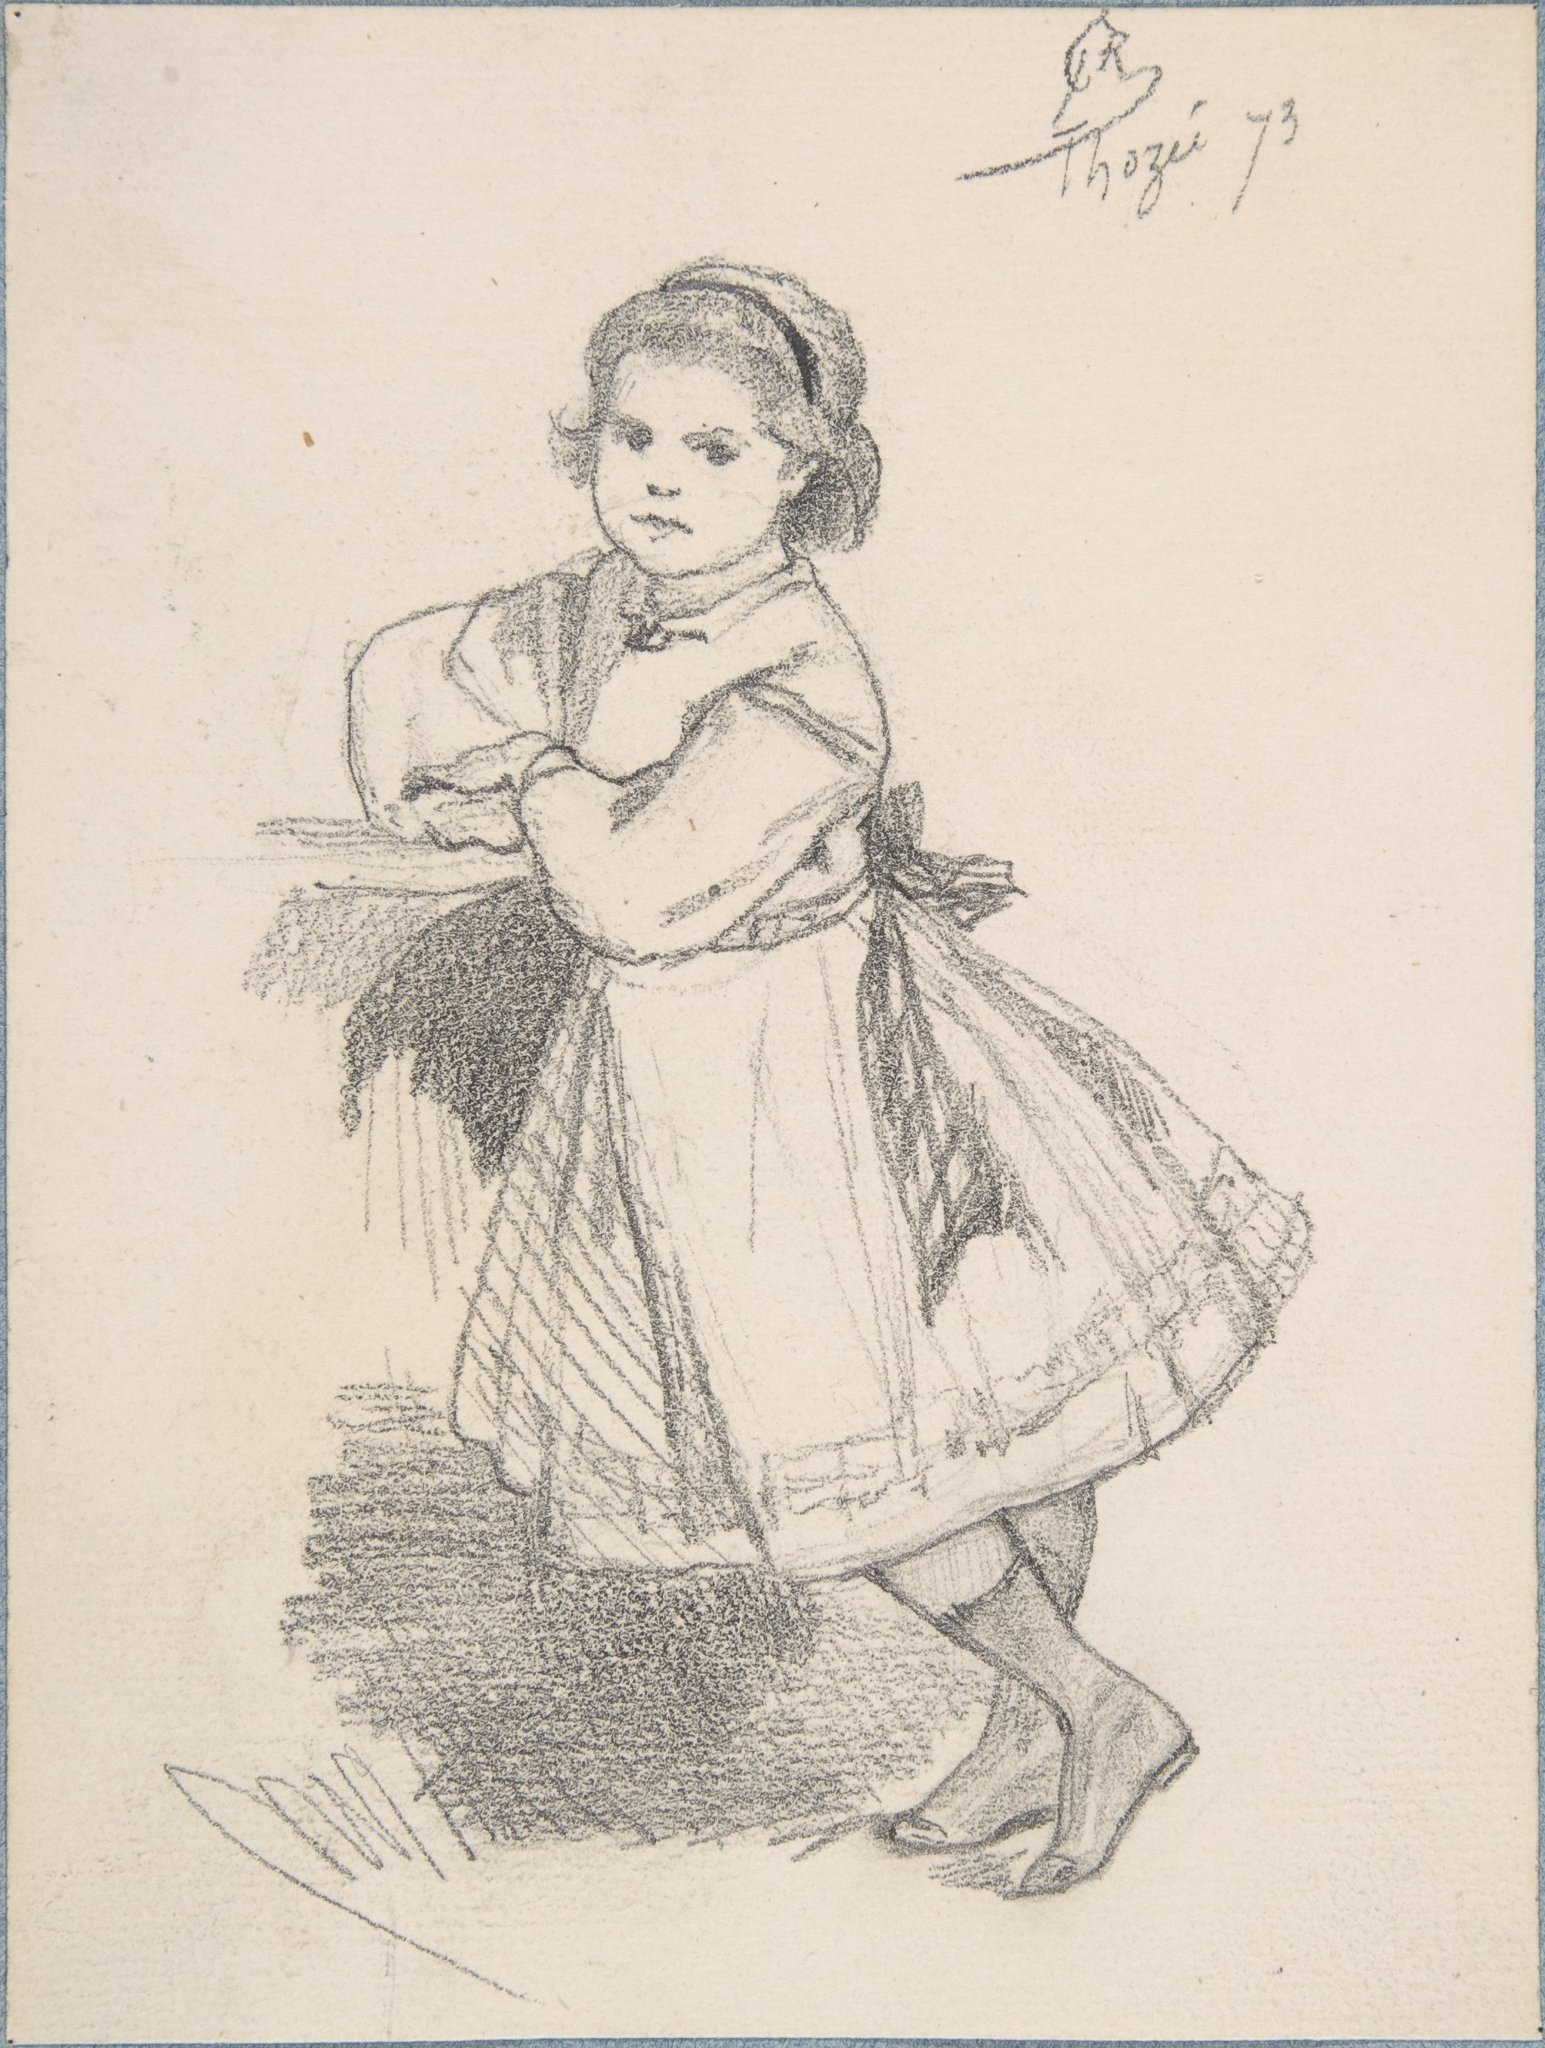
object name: drawing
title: Little Girl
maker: félicien rops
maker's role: artist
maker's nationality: belgian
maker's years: 1833-1898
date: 1873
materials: graphite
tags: girls